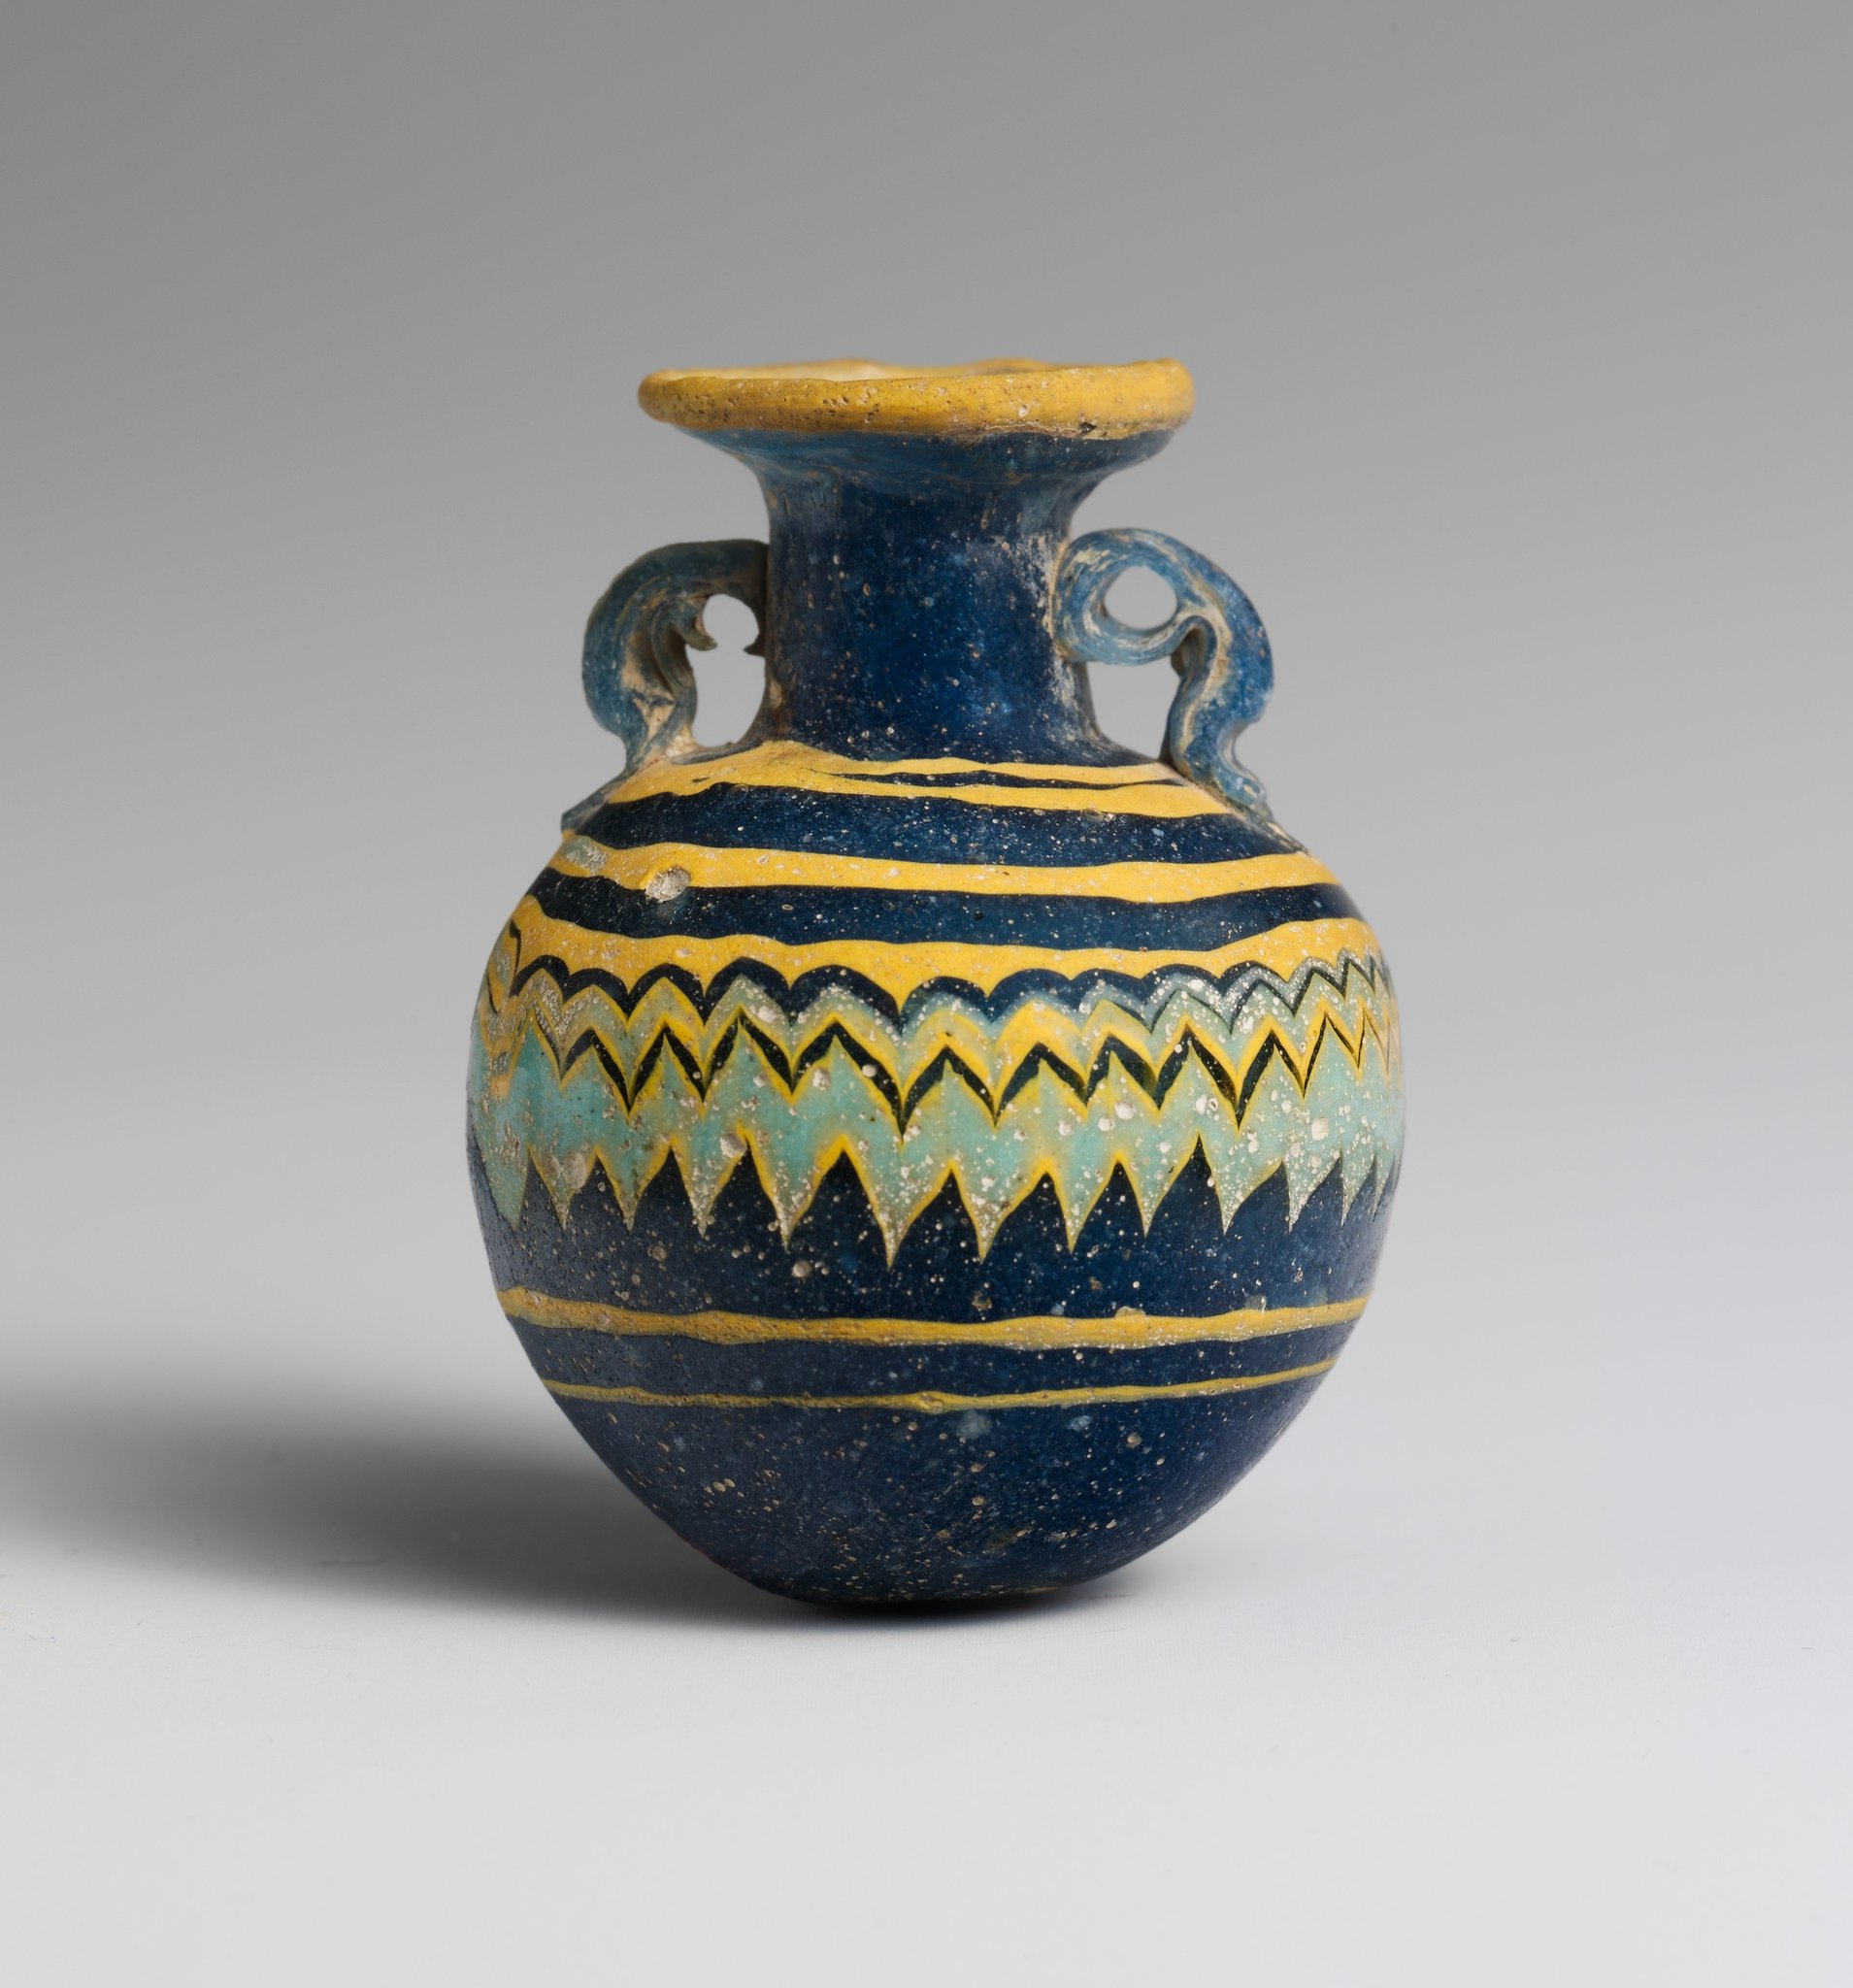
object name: aryballos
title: Glass aryballos (perfume bottle)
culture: greek, eastern mediterranean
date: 534-401 BCE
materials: glass